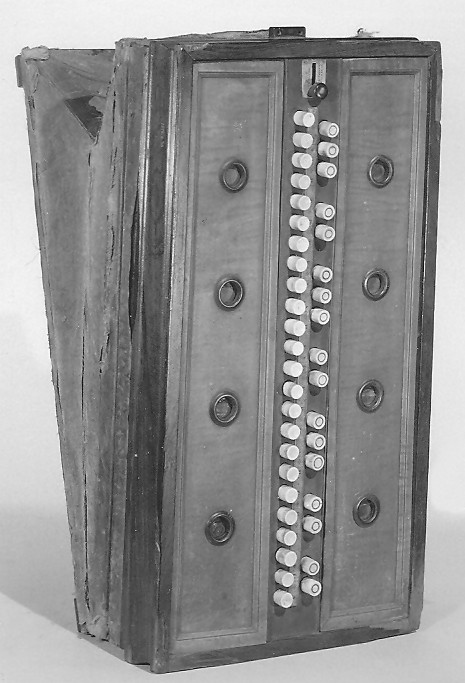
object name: rocking melodeon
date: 1847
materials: textile, leather, metal, wood